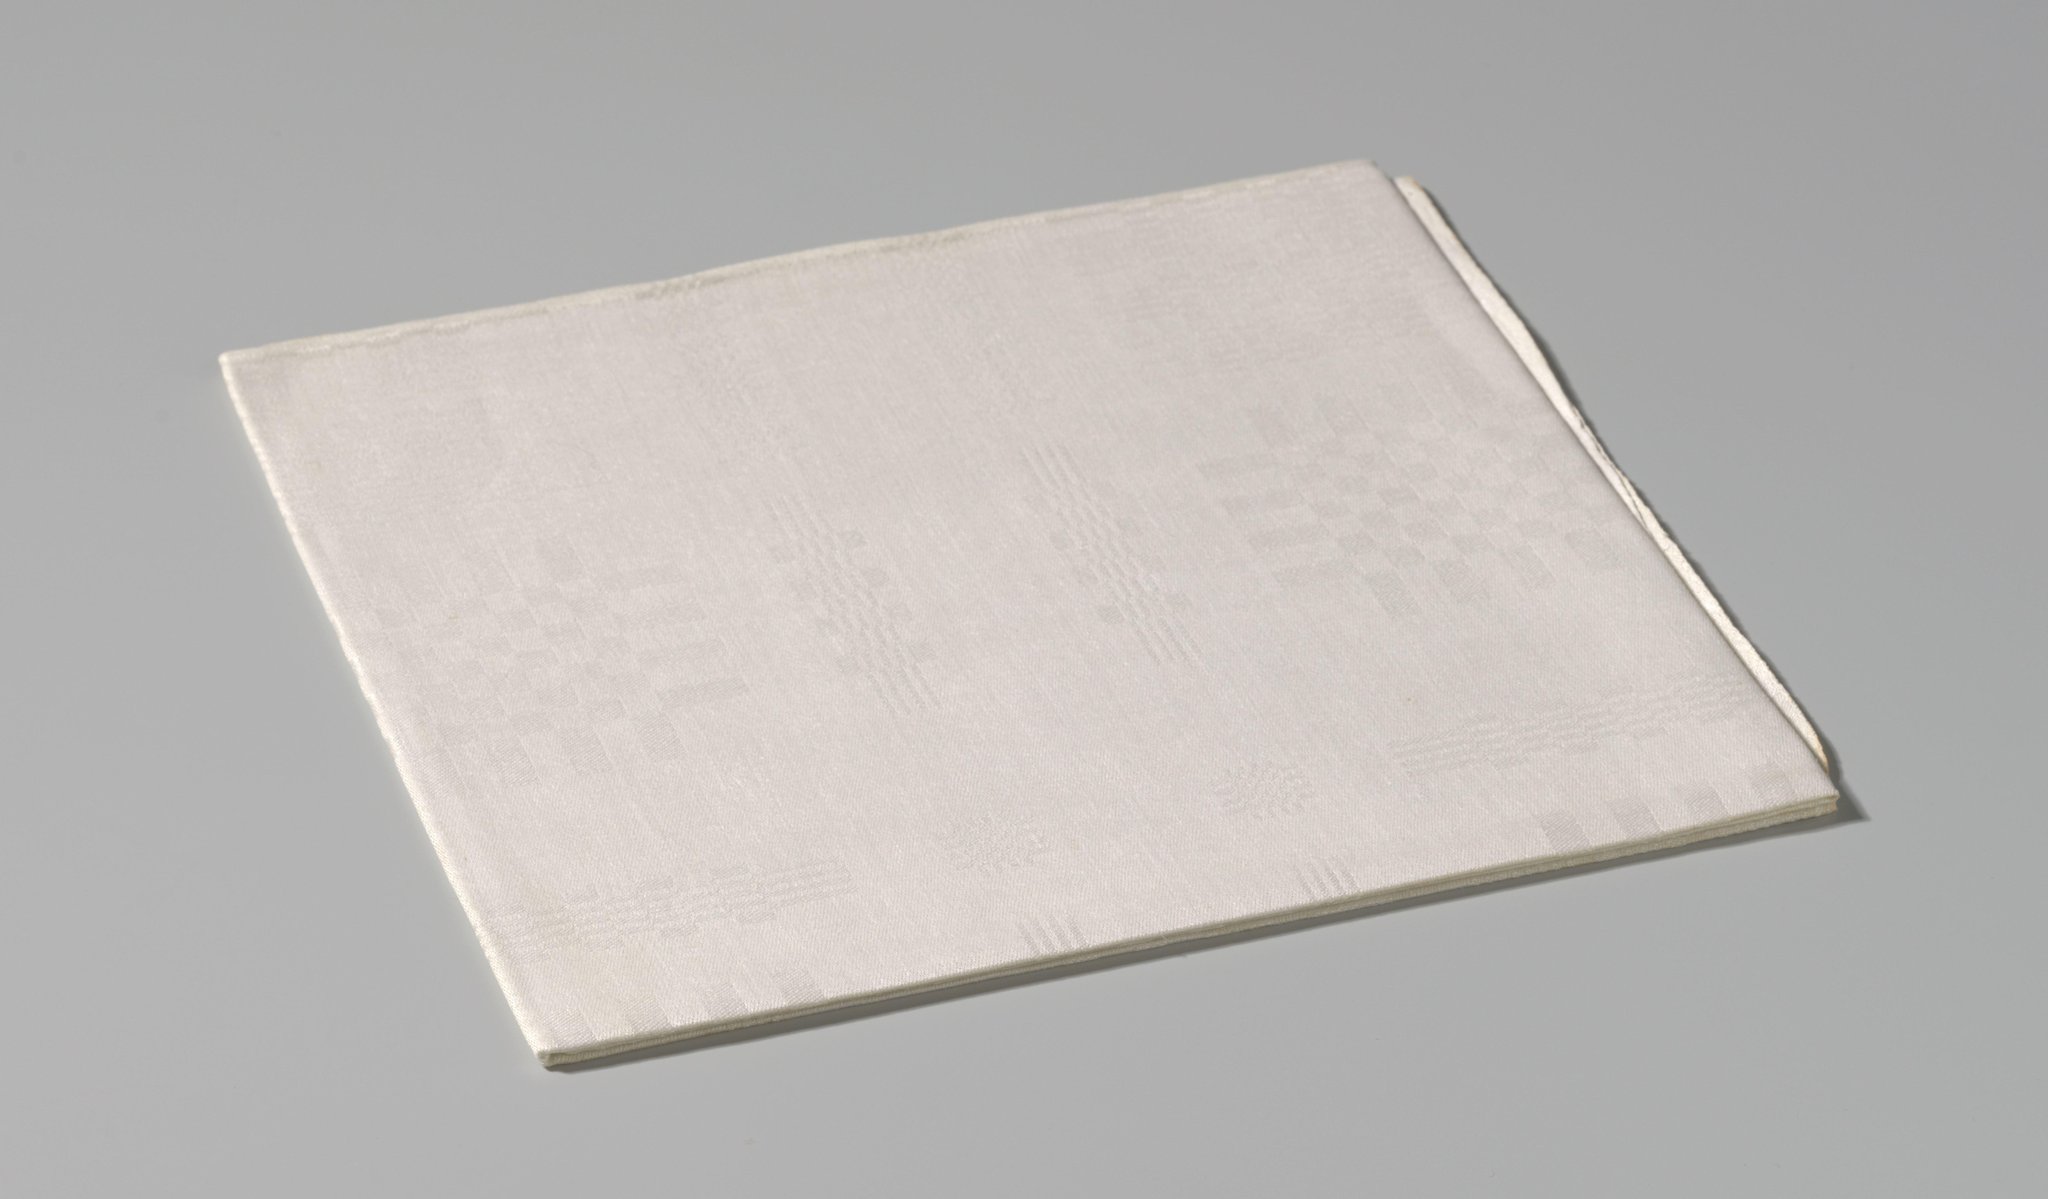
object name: napkin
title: Servet van linnen met pellenpatroon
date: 1888-1894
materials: linen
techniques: peeled fabric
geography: strijp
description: Wit linnen servet met pellen patroon "vierkant ruitje", merk Twickel 36.